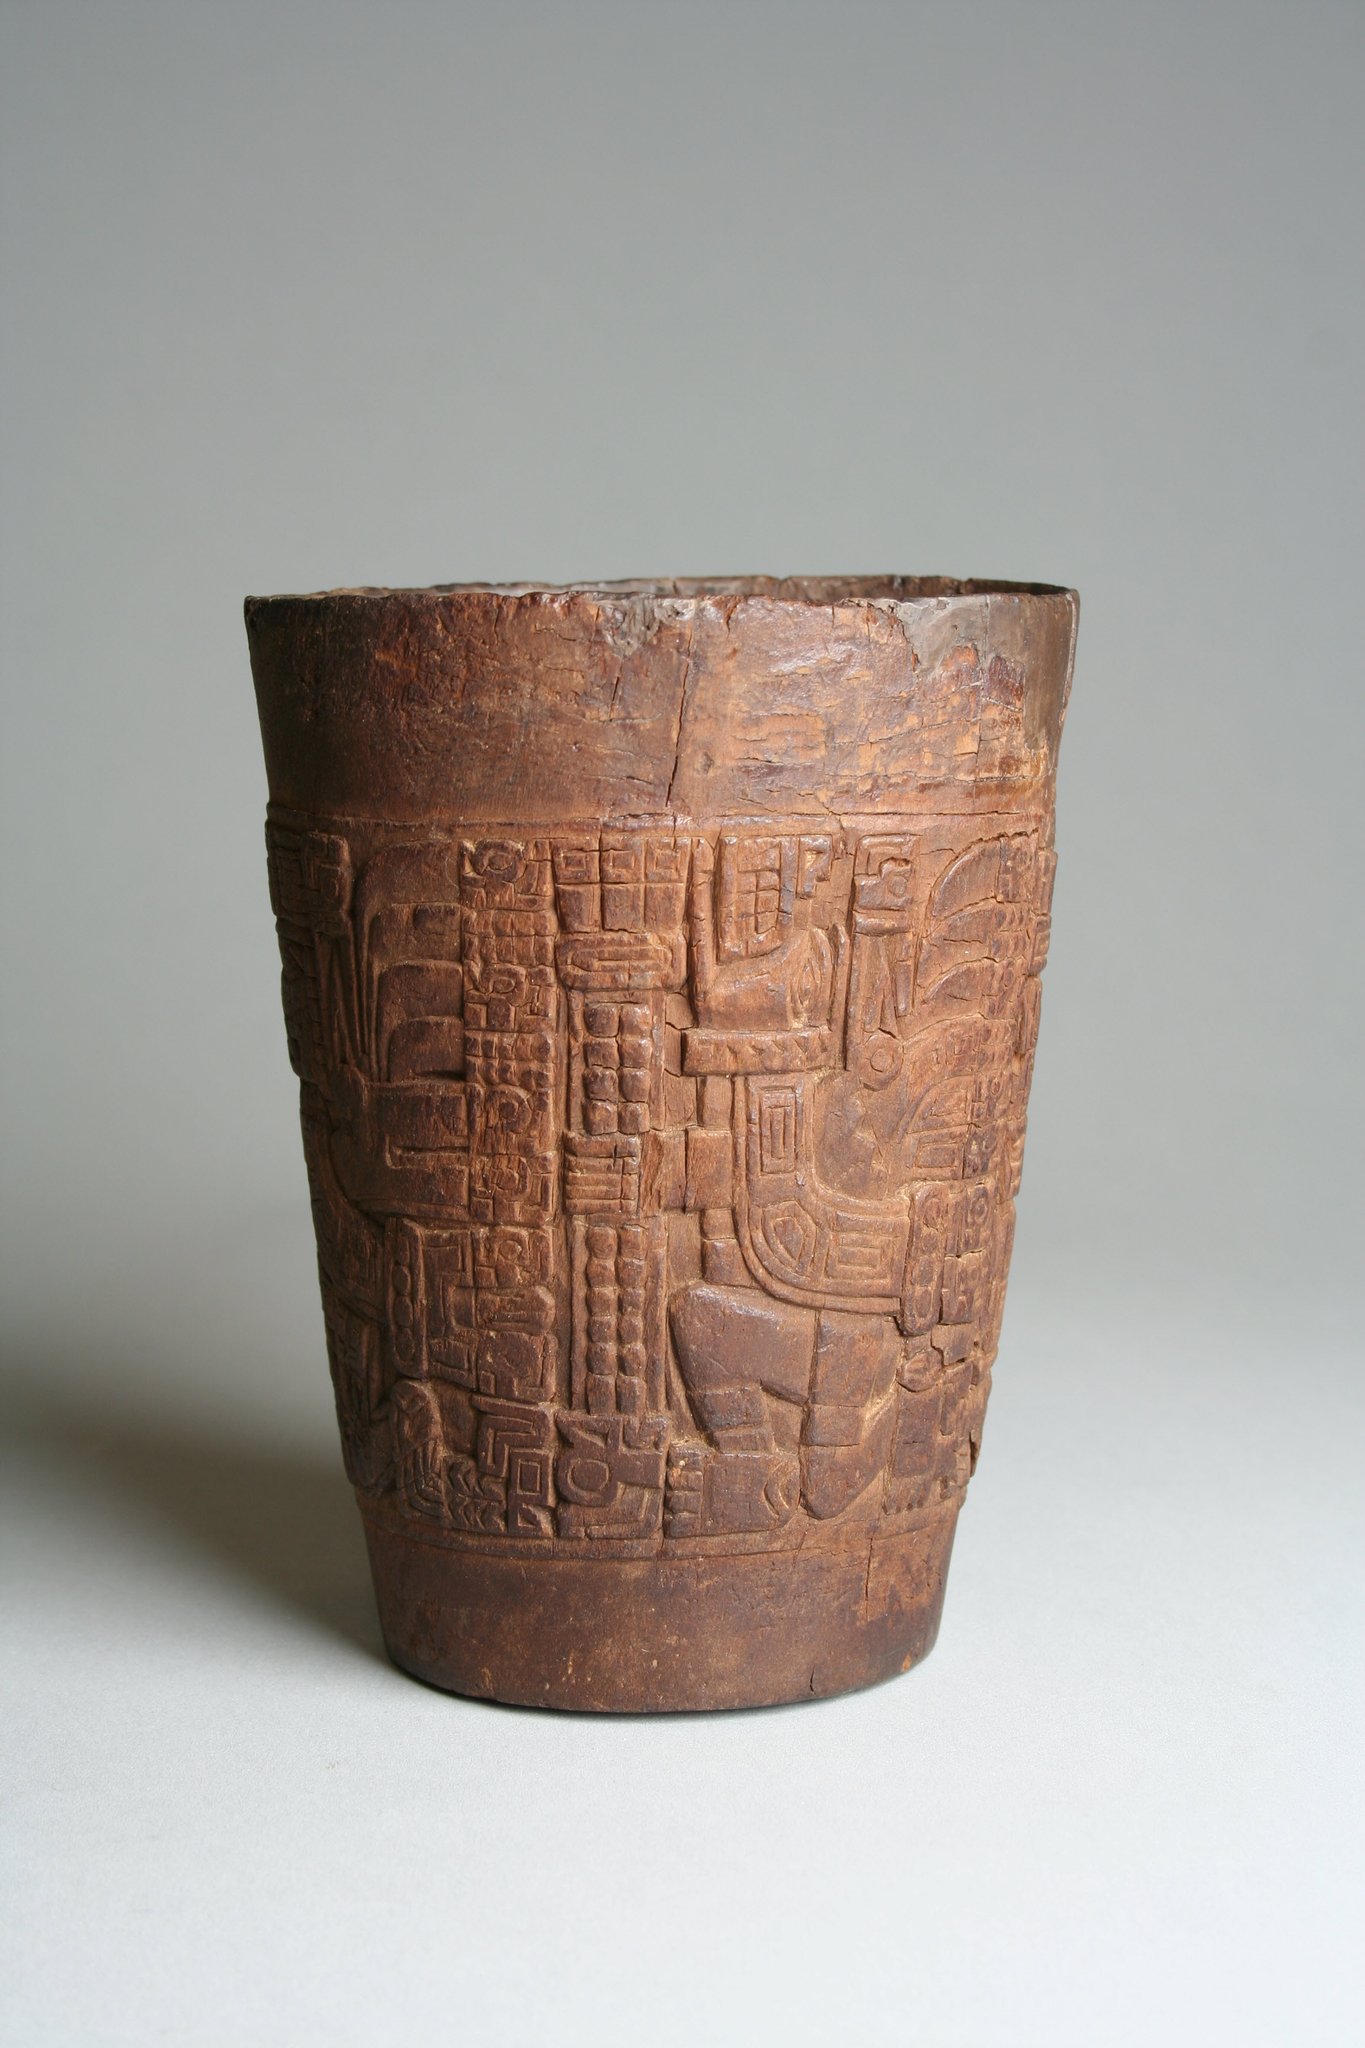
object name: beaker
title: Kero (beaker)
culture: tiwanaku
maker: tiwanaku artist(s)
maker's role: artist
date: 500-1000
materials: wood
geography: bolivia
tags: animals